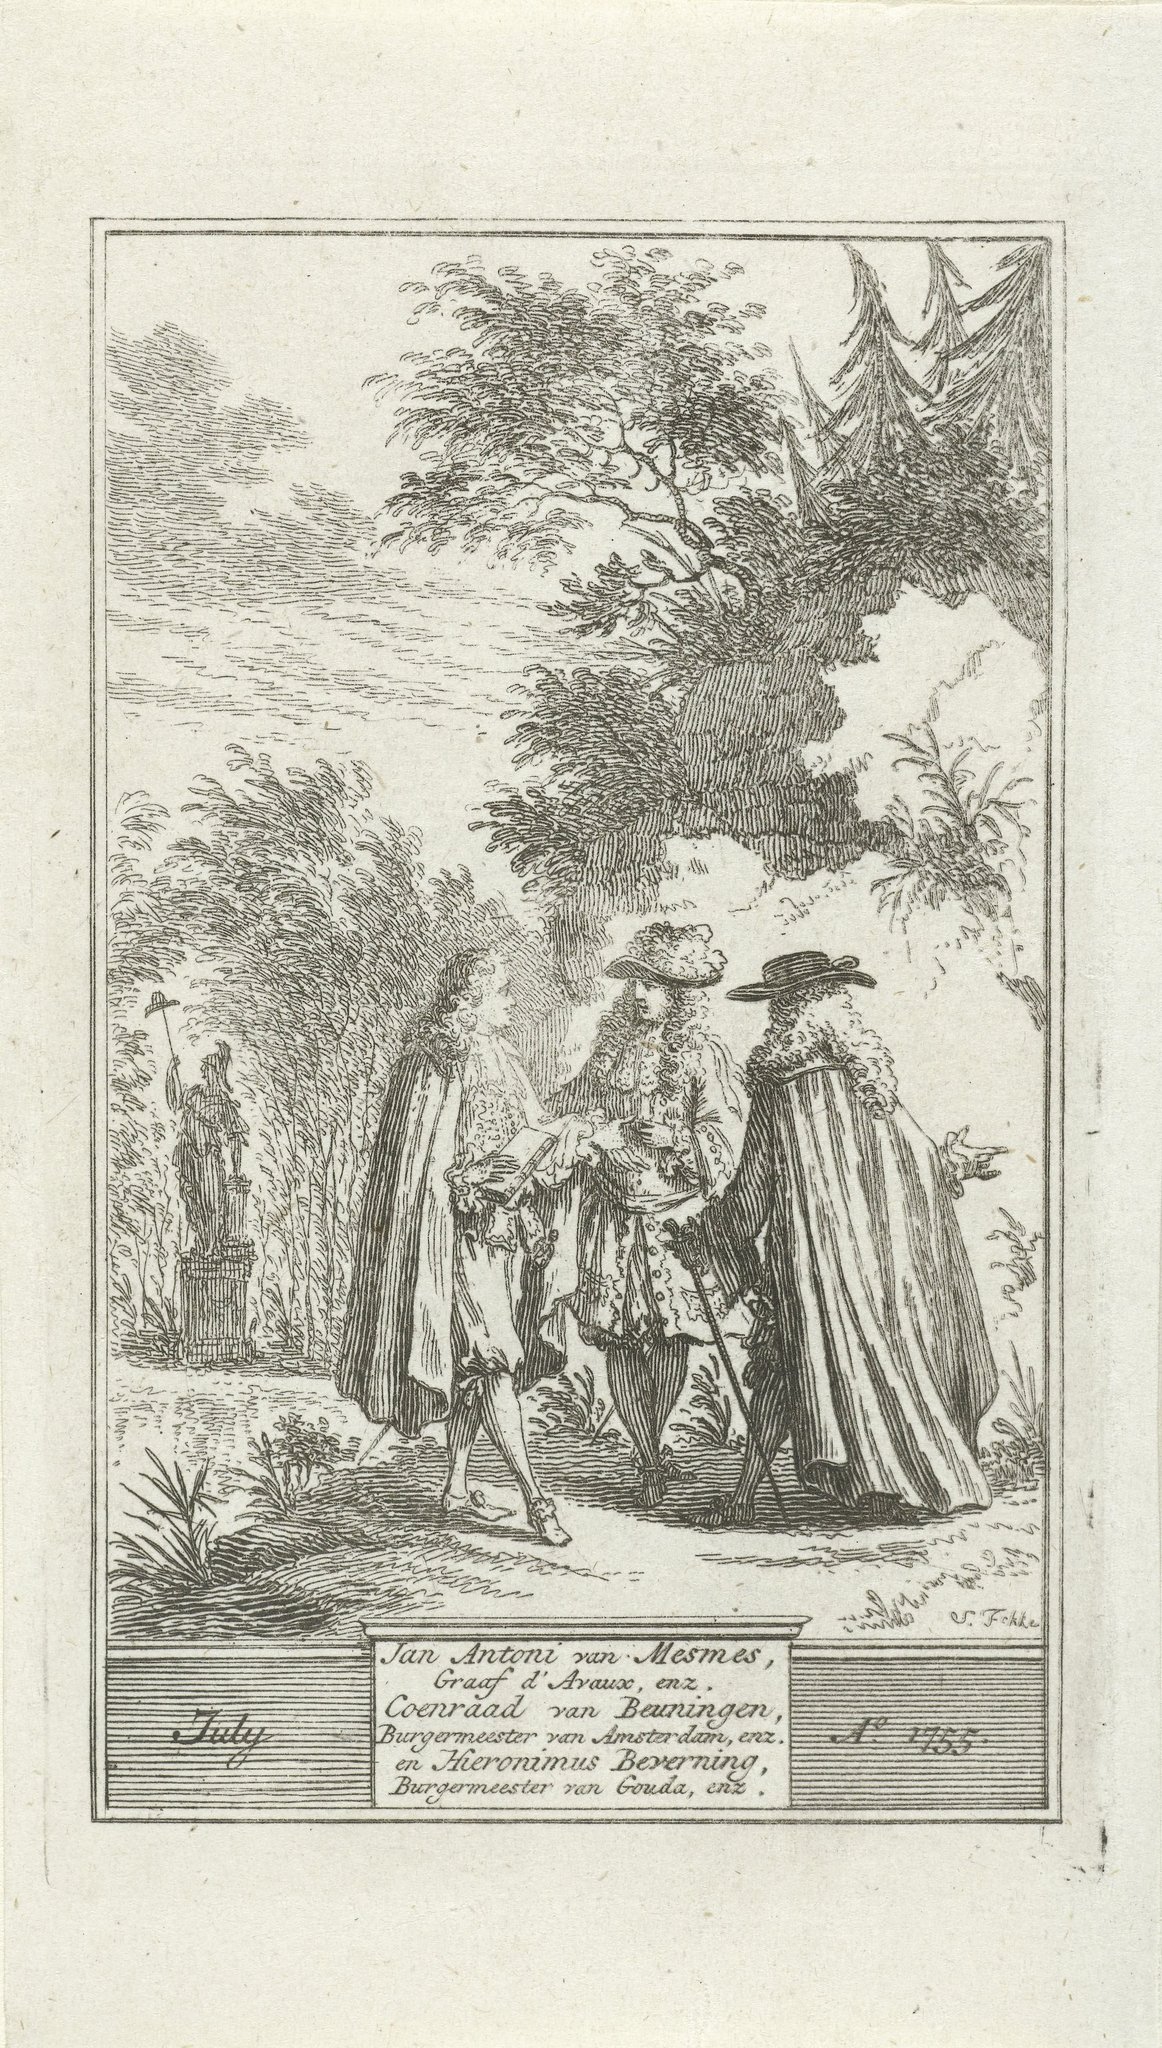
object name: print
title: Illustraties vaderlandse geschiedenis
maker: simon fokke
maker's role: draughtsman, print maker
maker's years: 1712-1784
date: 1722-1784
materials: paper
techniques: etching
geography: amsterdam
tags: leiden, mayor, freedom, liberty; 'libertà' (ripa)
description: De heren Jean Antoine de Mesmes, Coenraad van Beuningen en Hieronymus Beverningk in gesprek in de openlucht. Op de achtergrond een beeld van een vrouw met helm en vrijheidshoed op stok. Onder de afbeelding een tekst met de datum juli 1755.